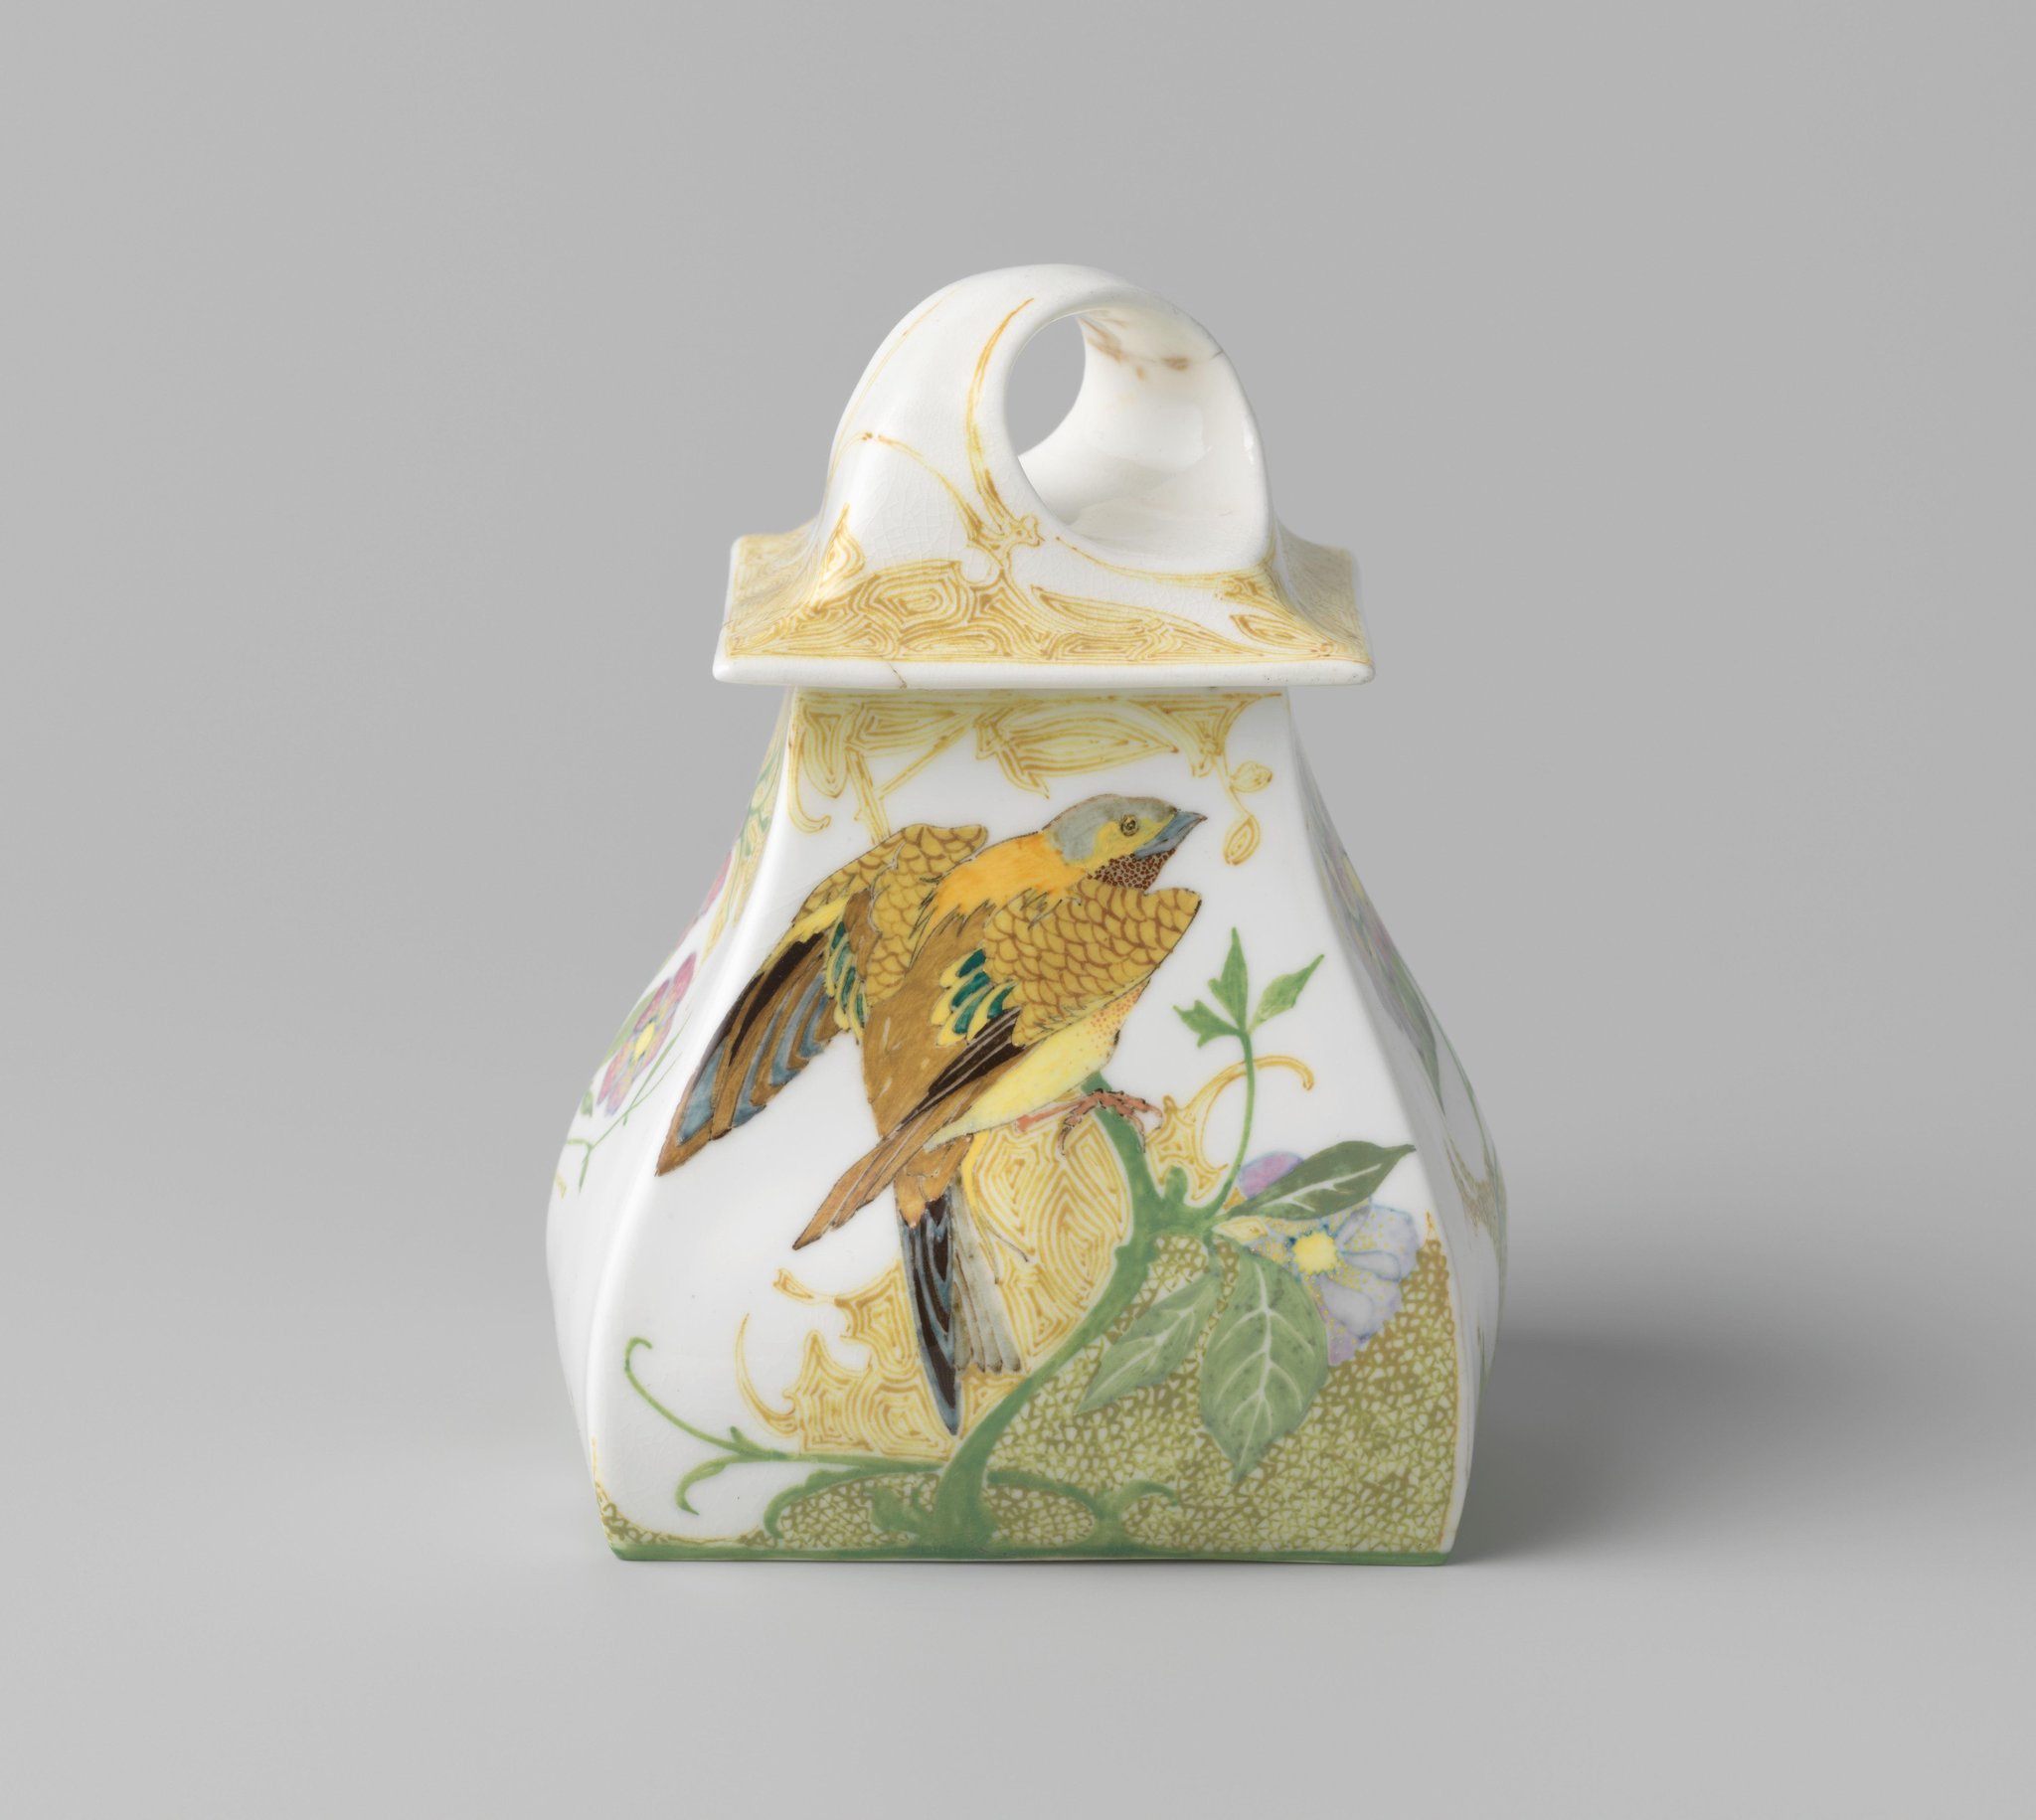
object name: inkwell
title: Inktpot van wit porselein versierd met primula's en vogels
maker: sam schellink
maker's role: ceramicist, draughtsman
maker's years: 1876-1958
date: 1900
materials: porcelain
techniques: painted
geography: the hague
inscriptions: mark: ‘kroon // Rozenburg // ooievaar // den Haag (in groen) ; jaarteken ; werkordernummer 475 ; schildersmerk doorsneden S ; 139 (134?) (ingegrift)’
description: Inktpot van wit porselein. Op de vier gewelfde zijden, zijn afwisselend een tak primula's of een exotische vogel op tak in lichte tinten geschilderd. Het vierkante deksel is voorzien van een handvat.